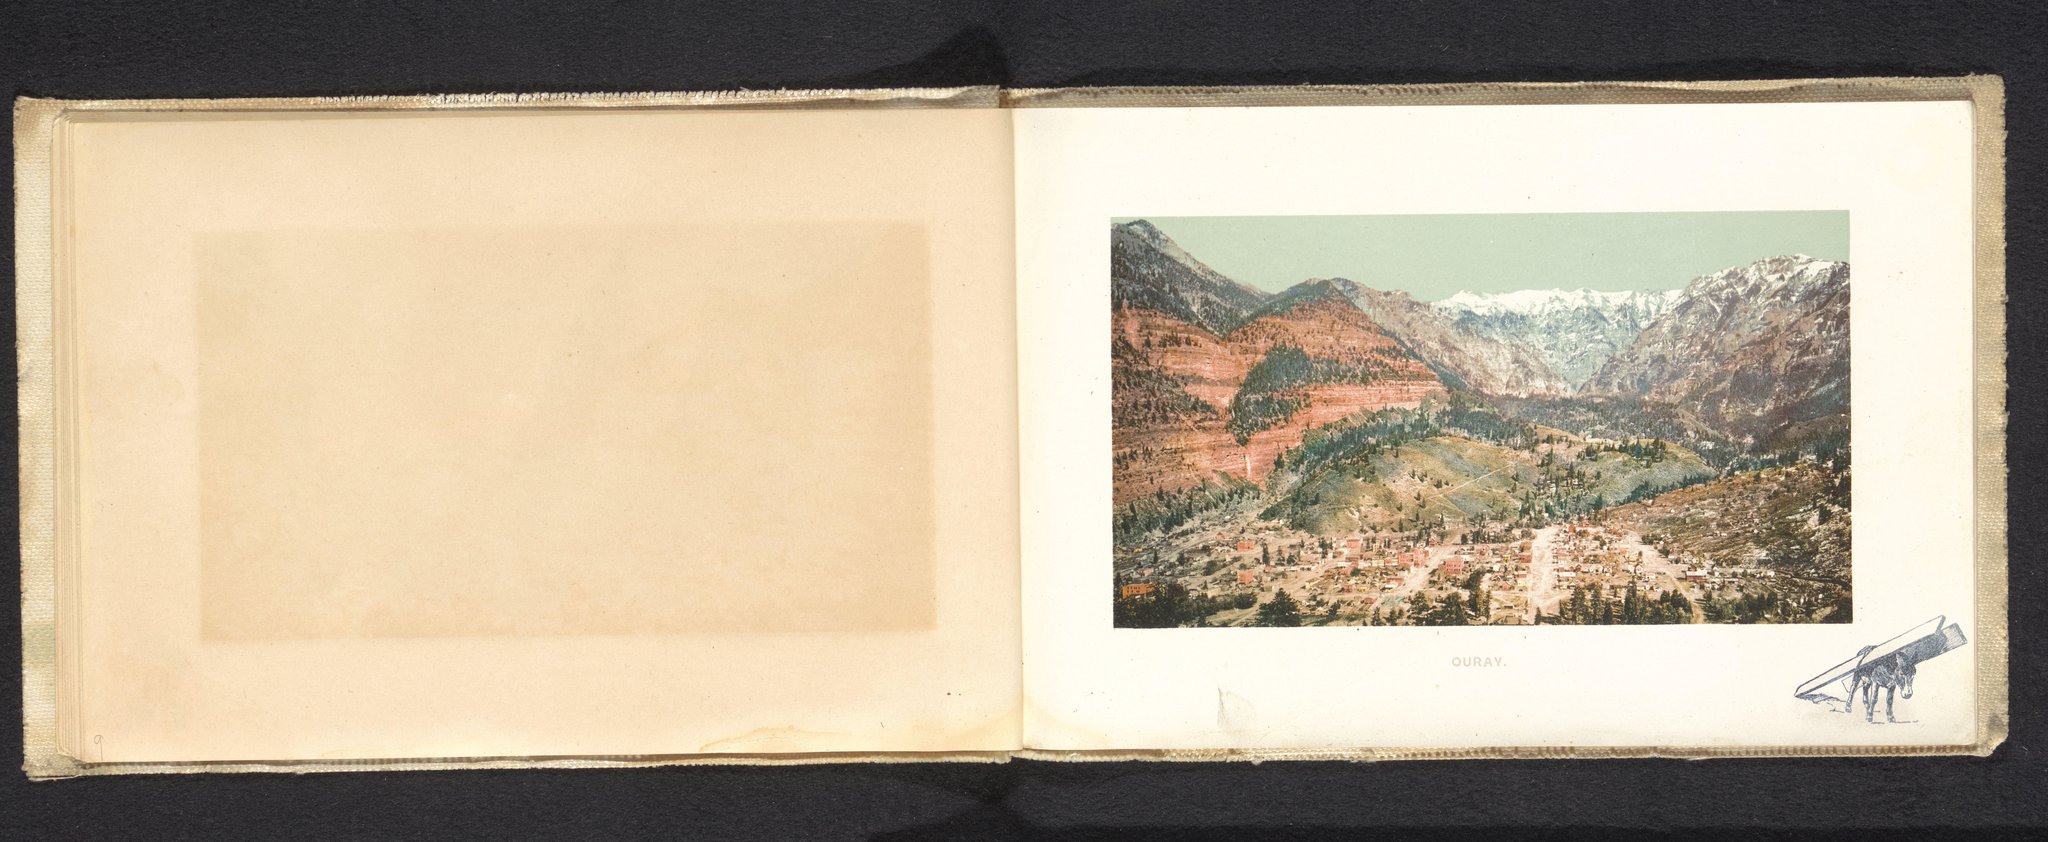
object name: page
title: Ouray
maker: Anonymous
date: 1894-1899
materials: paper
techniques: lithograph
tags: city-view in general; 'veduta', mountains